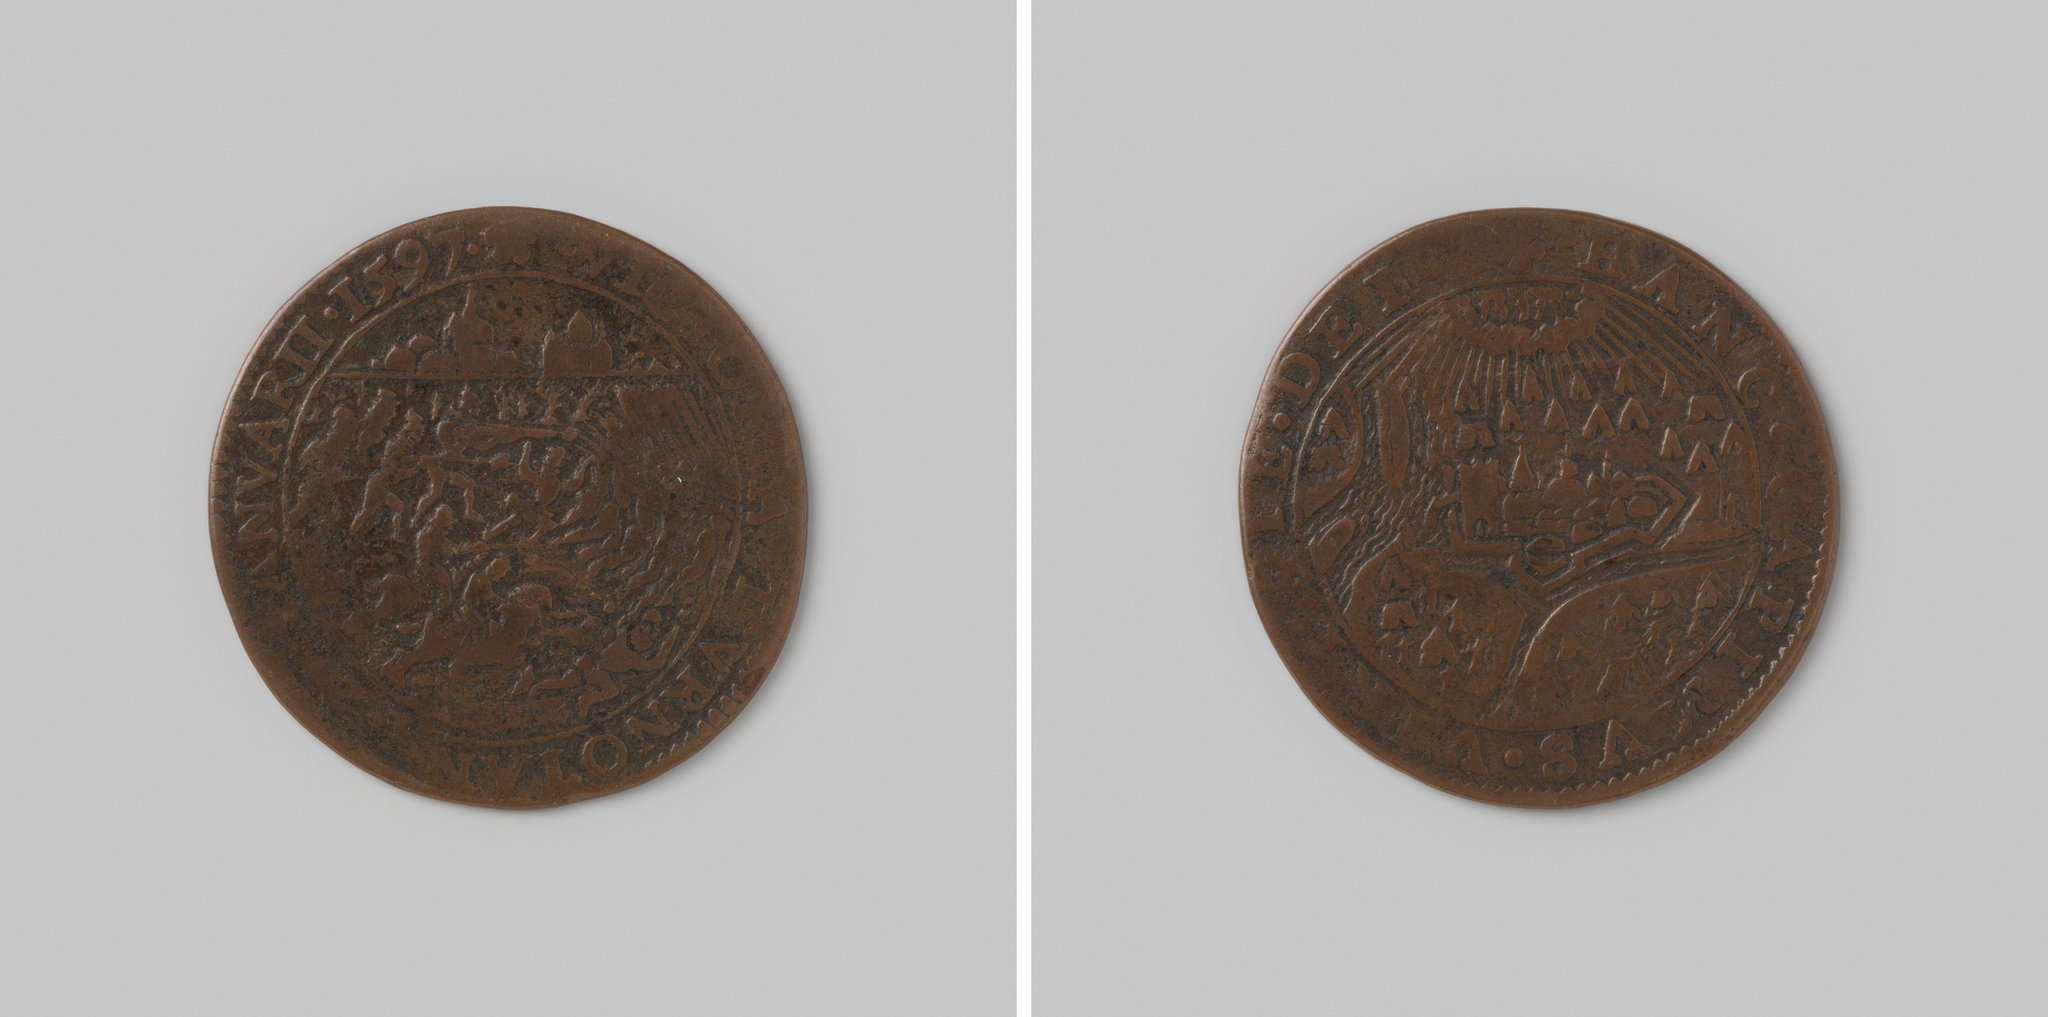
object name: history medal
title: Rekenpenning uit Dordrecht op de overwinning in de Slag bij bij Turnhout 1597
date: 1597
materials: copper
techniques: striking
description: Koperen penning, op de voorzijde het verdrijven van het vijandelijke leger, met omschrift, op de keerzijde een stad te midden van legerkampen onder de stralende naam Gods, met omschrift.